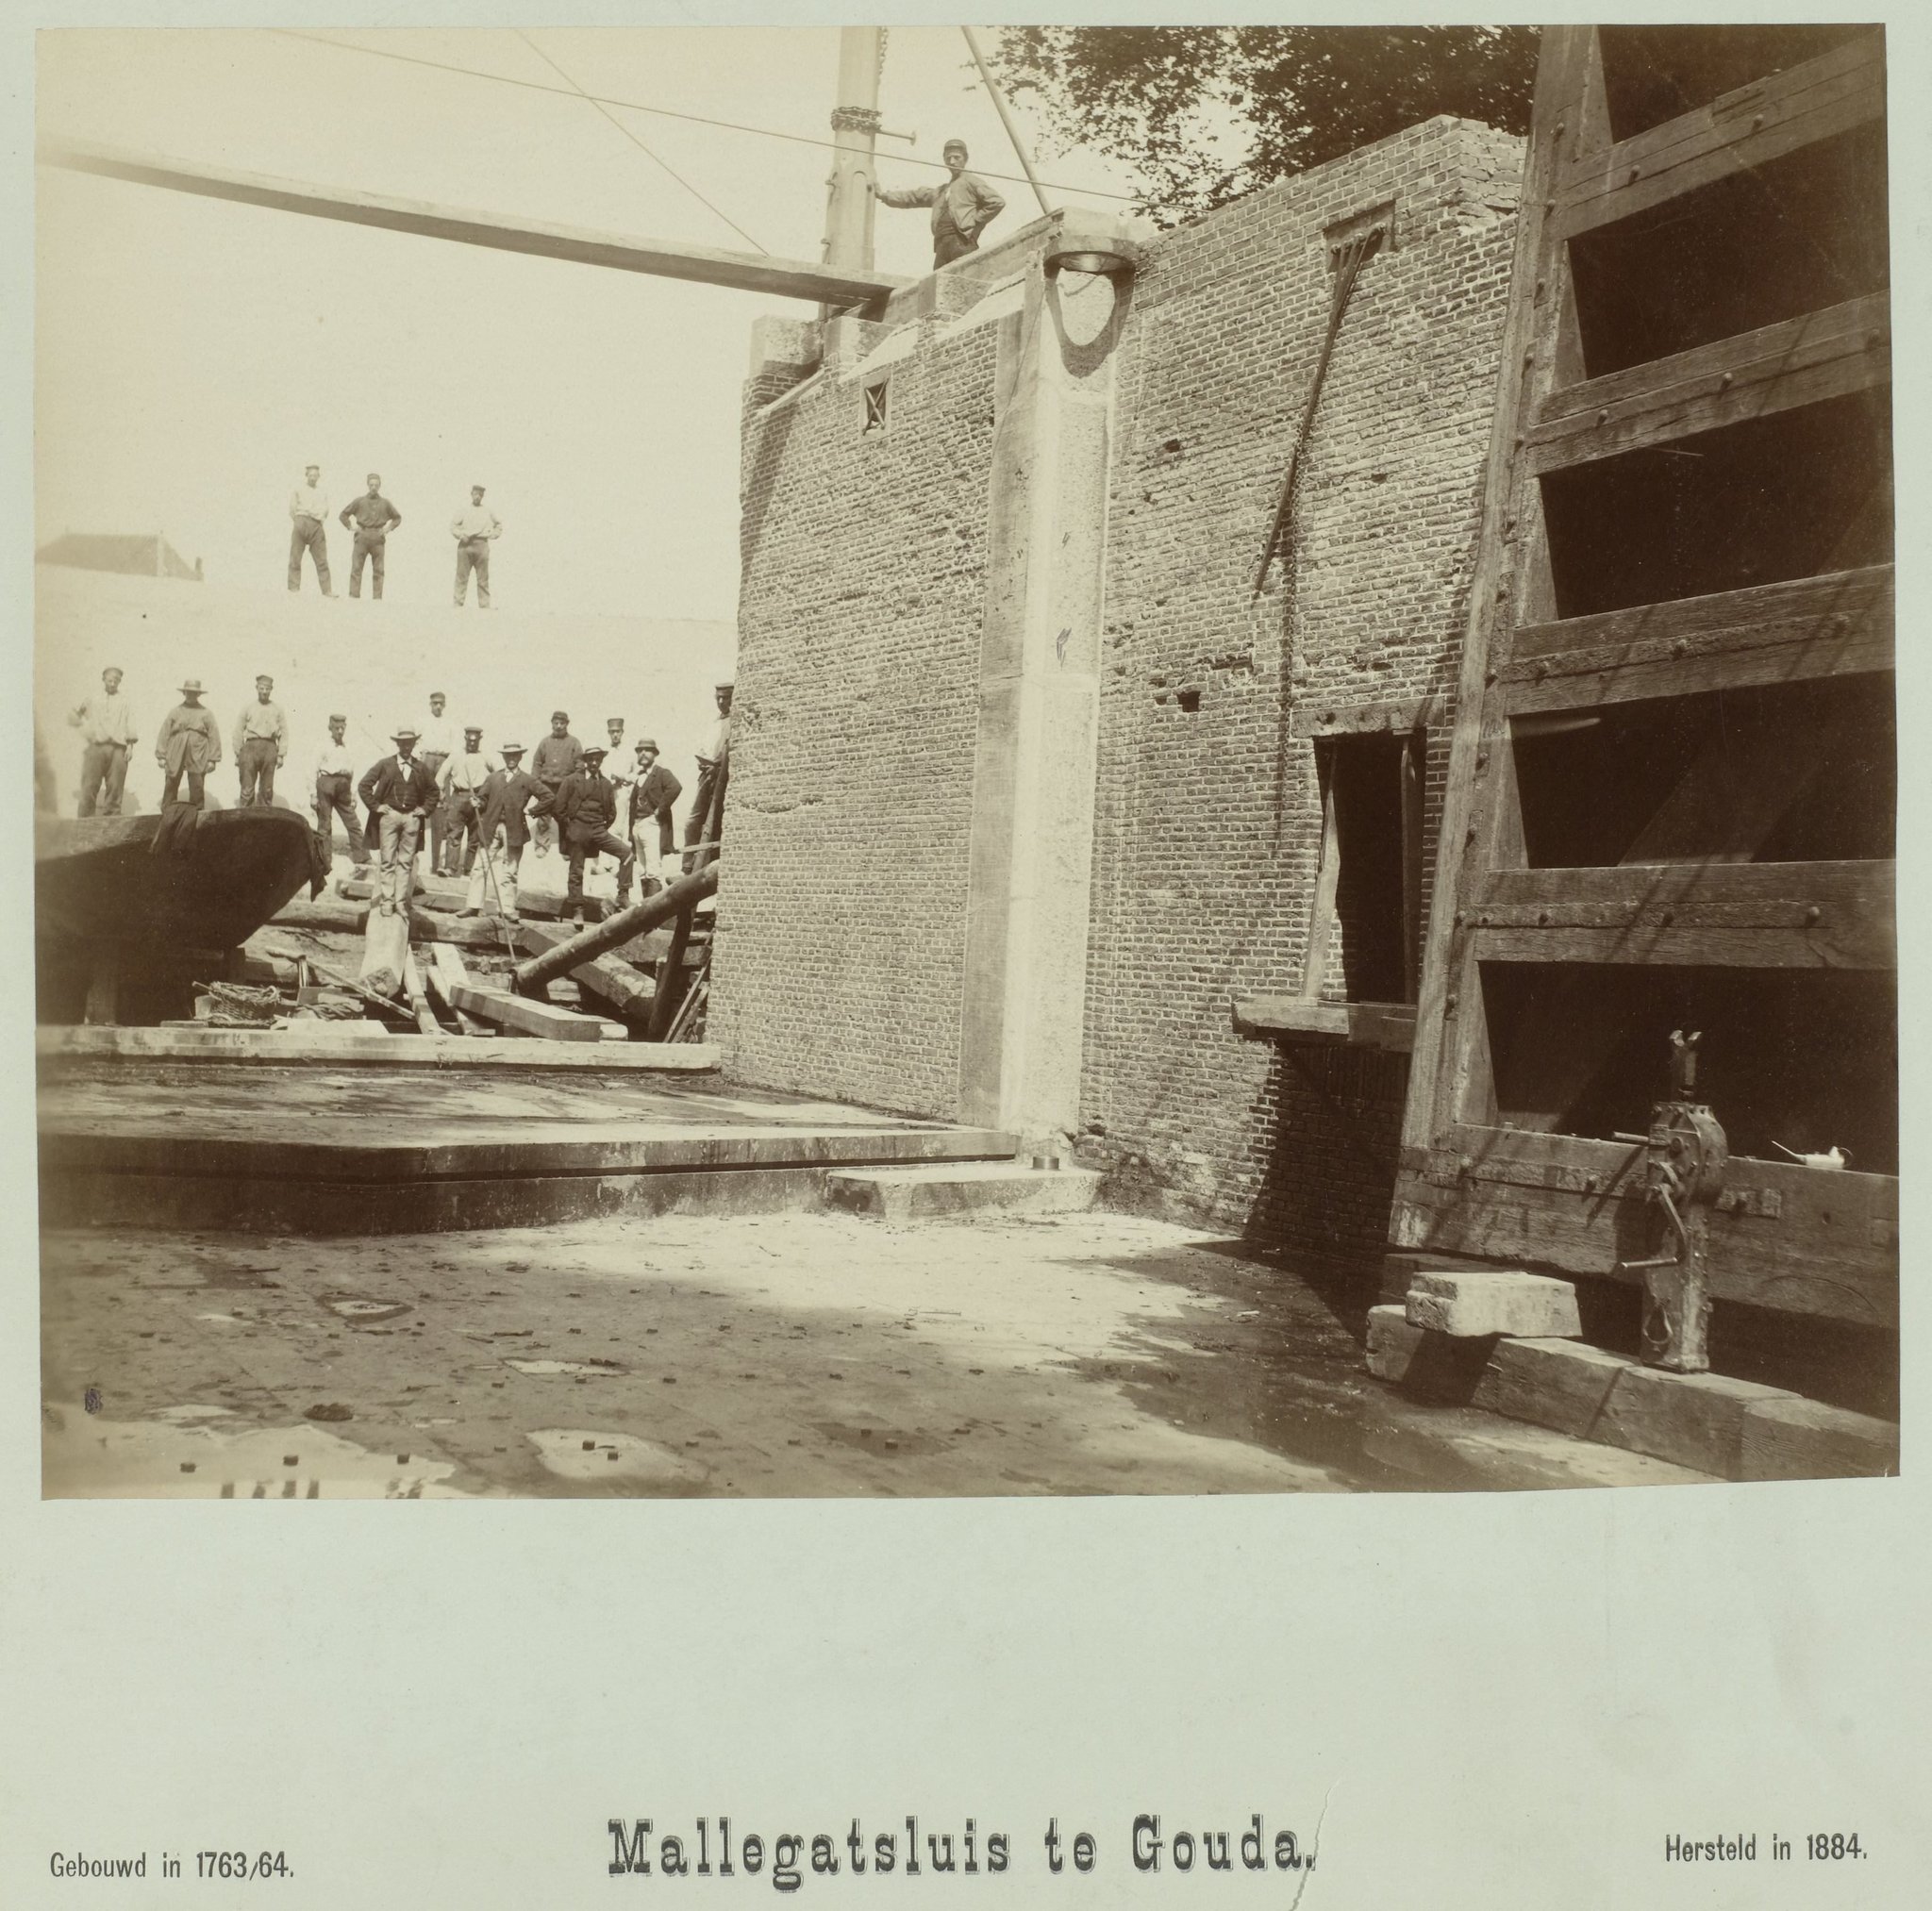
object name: photograph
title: Verbouwing Sluis aan den Leydschen Dam 1886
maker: Anonymous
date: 1884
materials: cardboard, paper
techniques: photography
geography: gouda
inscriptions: date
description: Foto op karton van de verbouwing van een sluis. Gesigneerd en gedateerd.